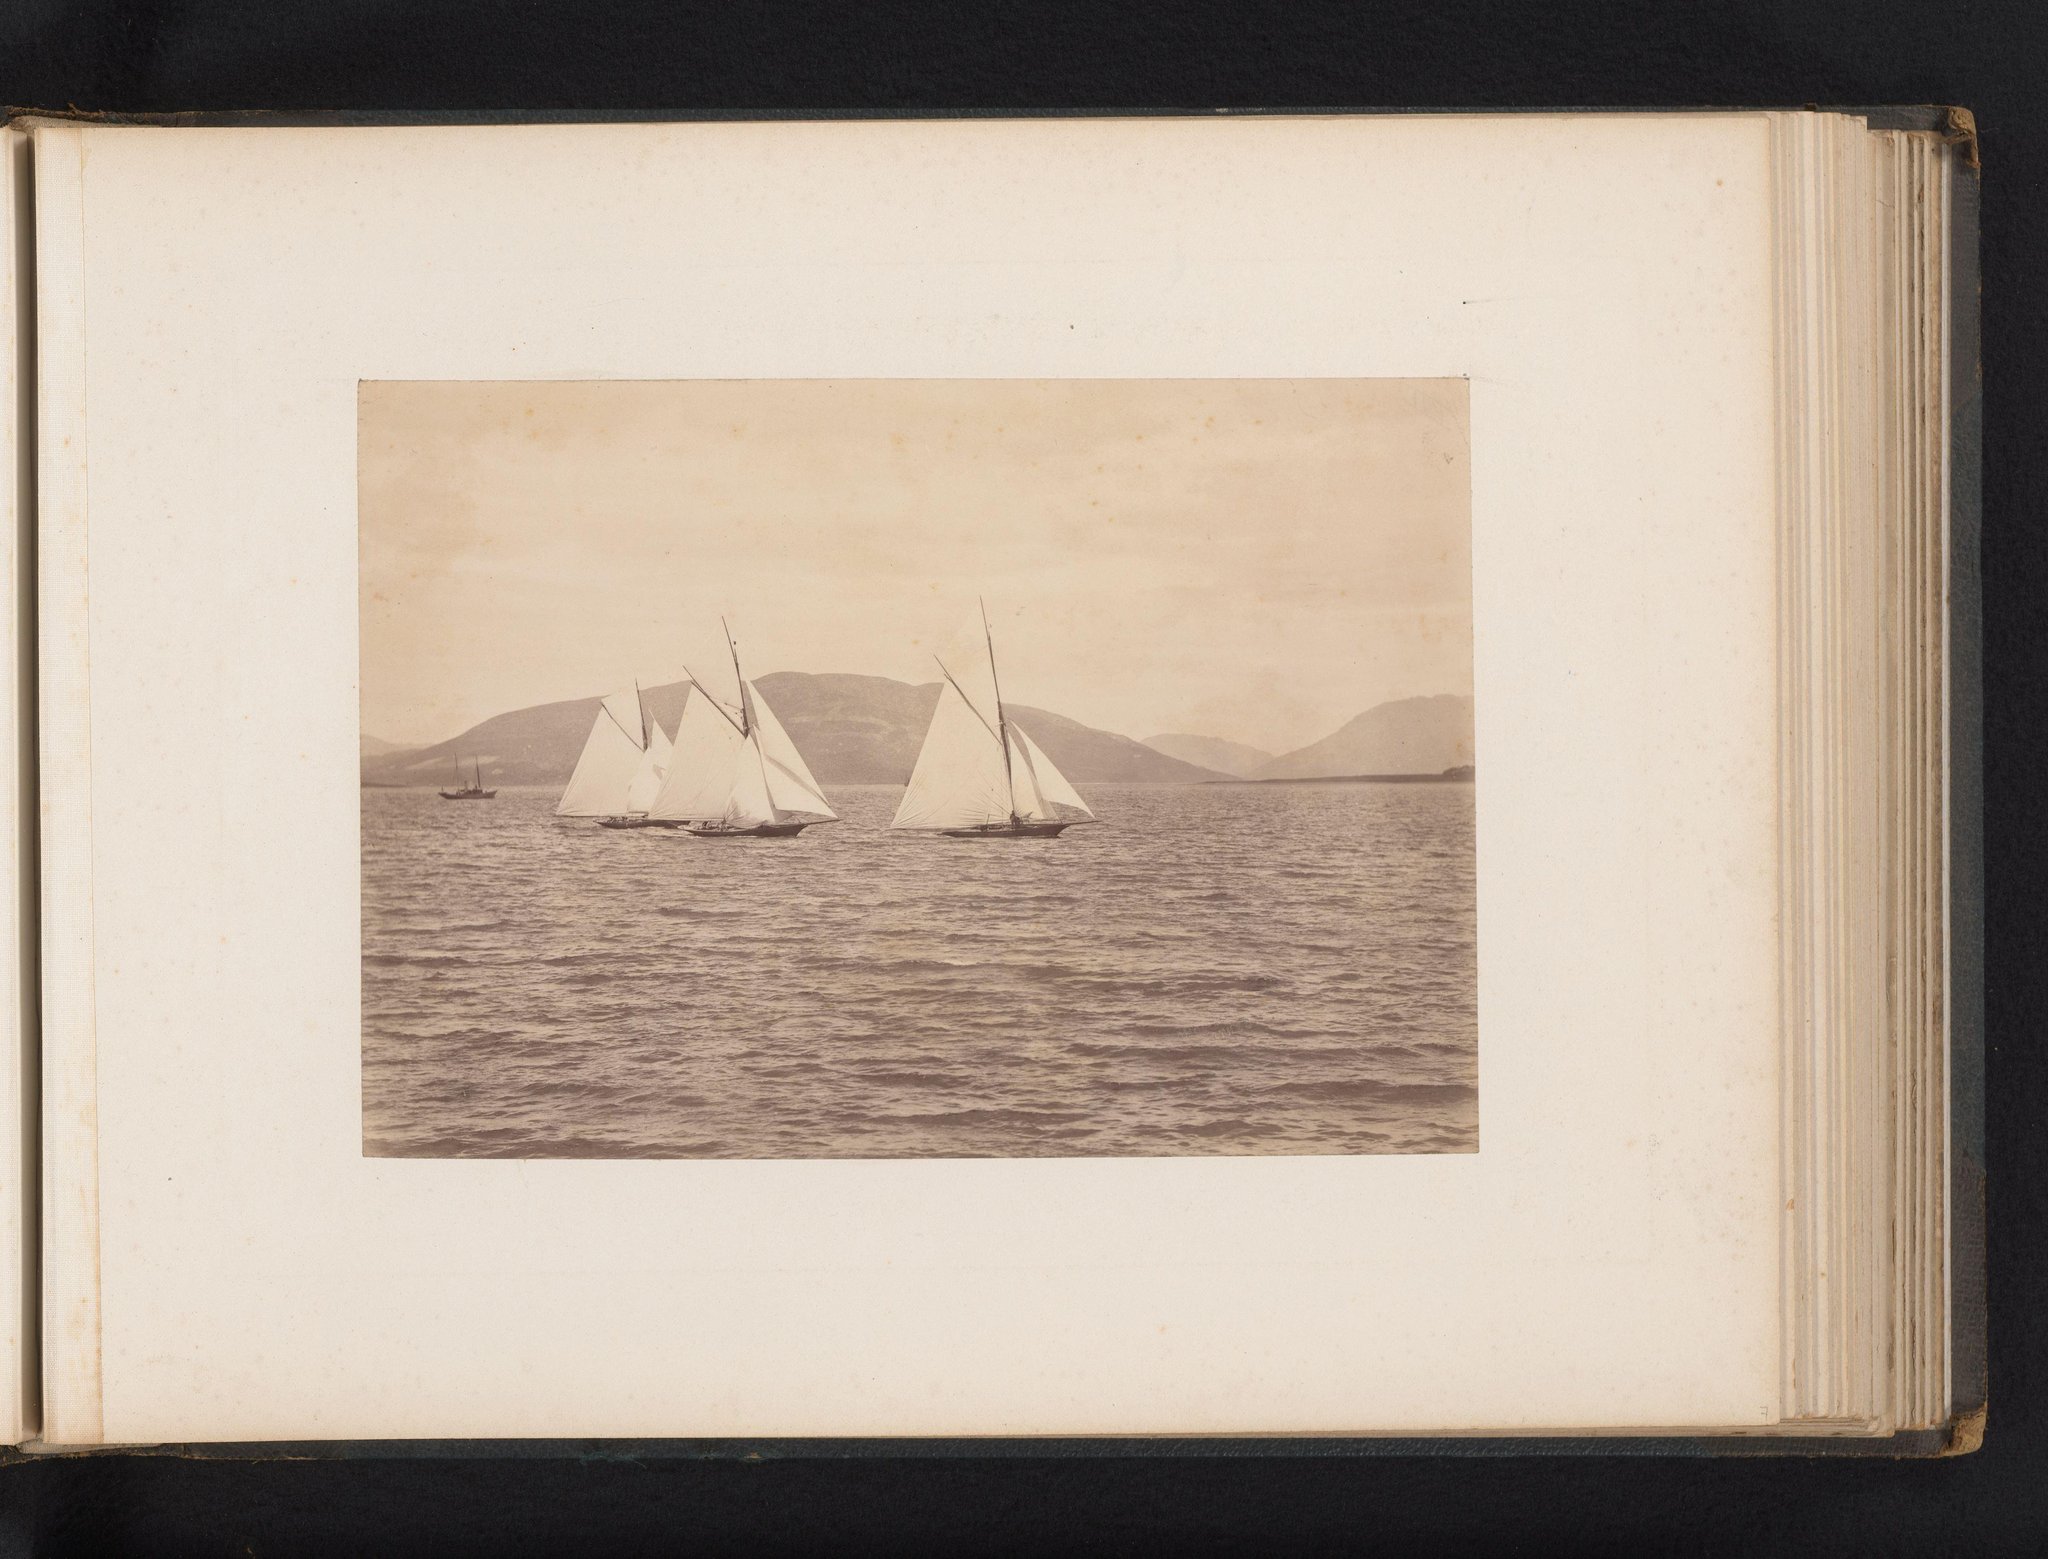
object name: photograph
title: Zeilschepen Maida, Yvonne en Encore te water met op de achtergrond een heuvelachtig landschap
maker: james adamson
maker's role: fotograaf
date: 1880-1900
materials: photographic support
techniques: albumen print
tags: sailing-ship, sailing-boat, landscapes with waters, waterscapes, seascapes (in the temperate zone), (high) hill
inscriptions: check stamp: ‘Adamson, Rothesay.H.B’